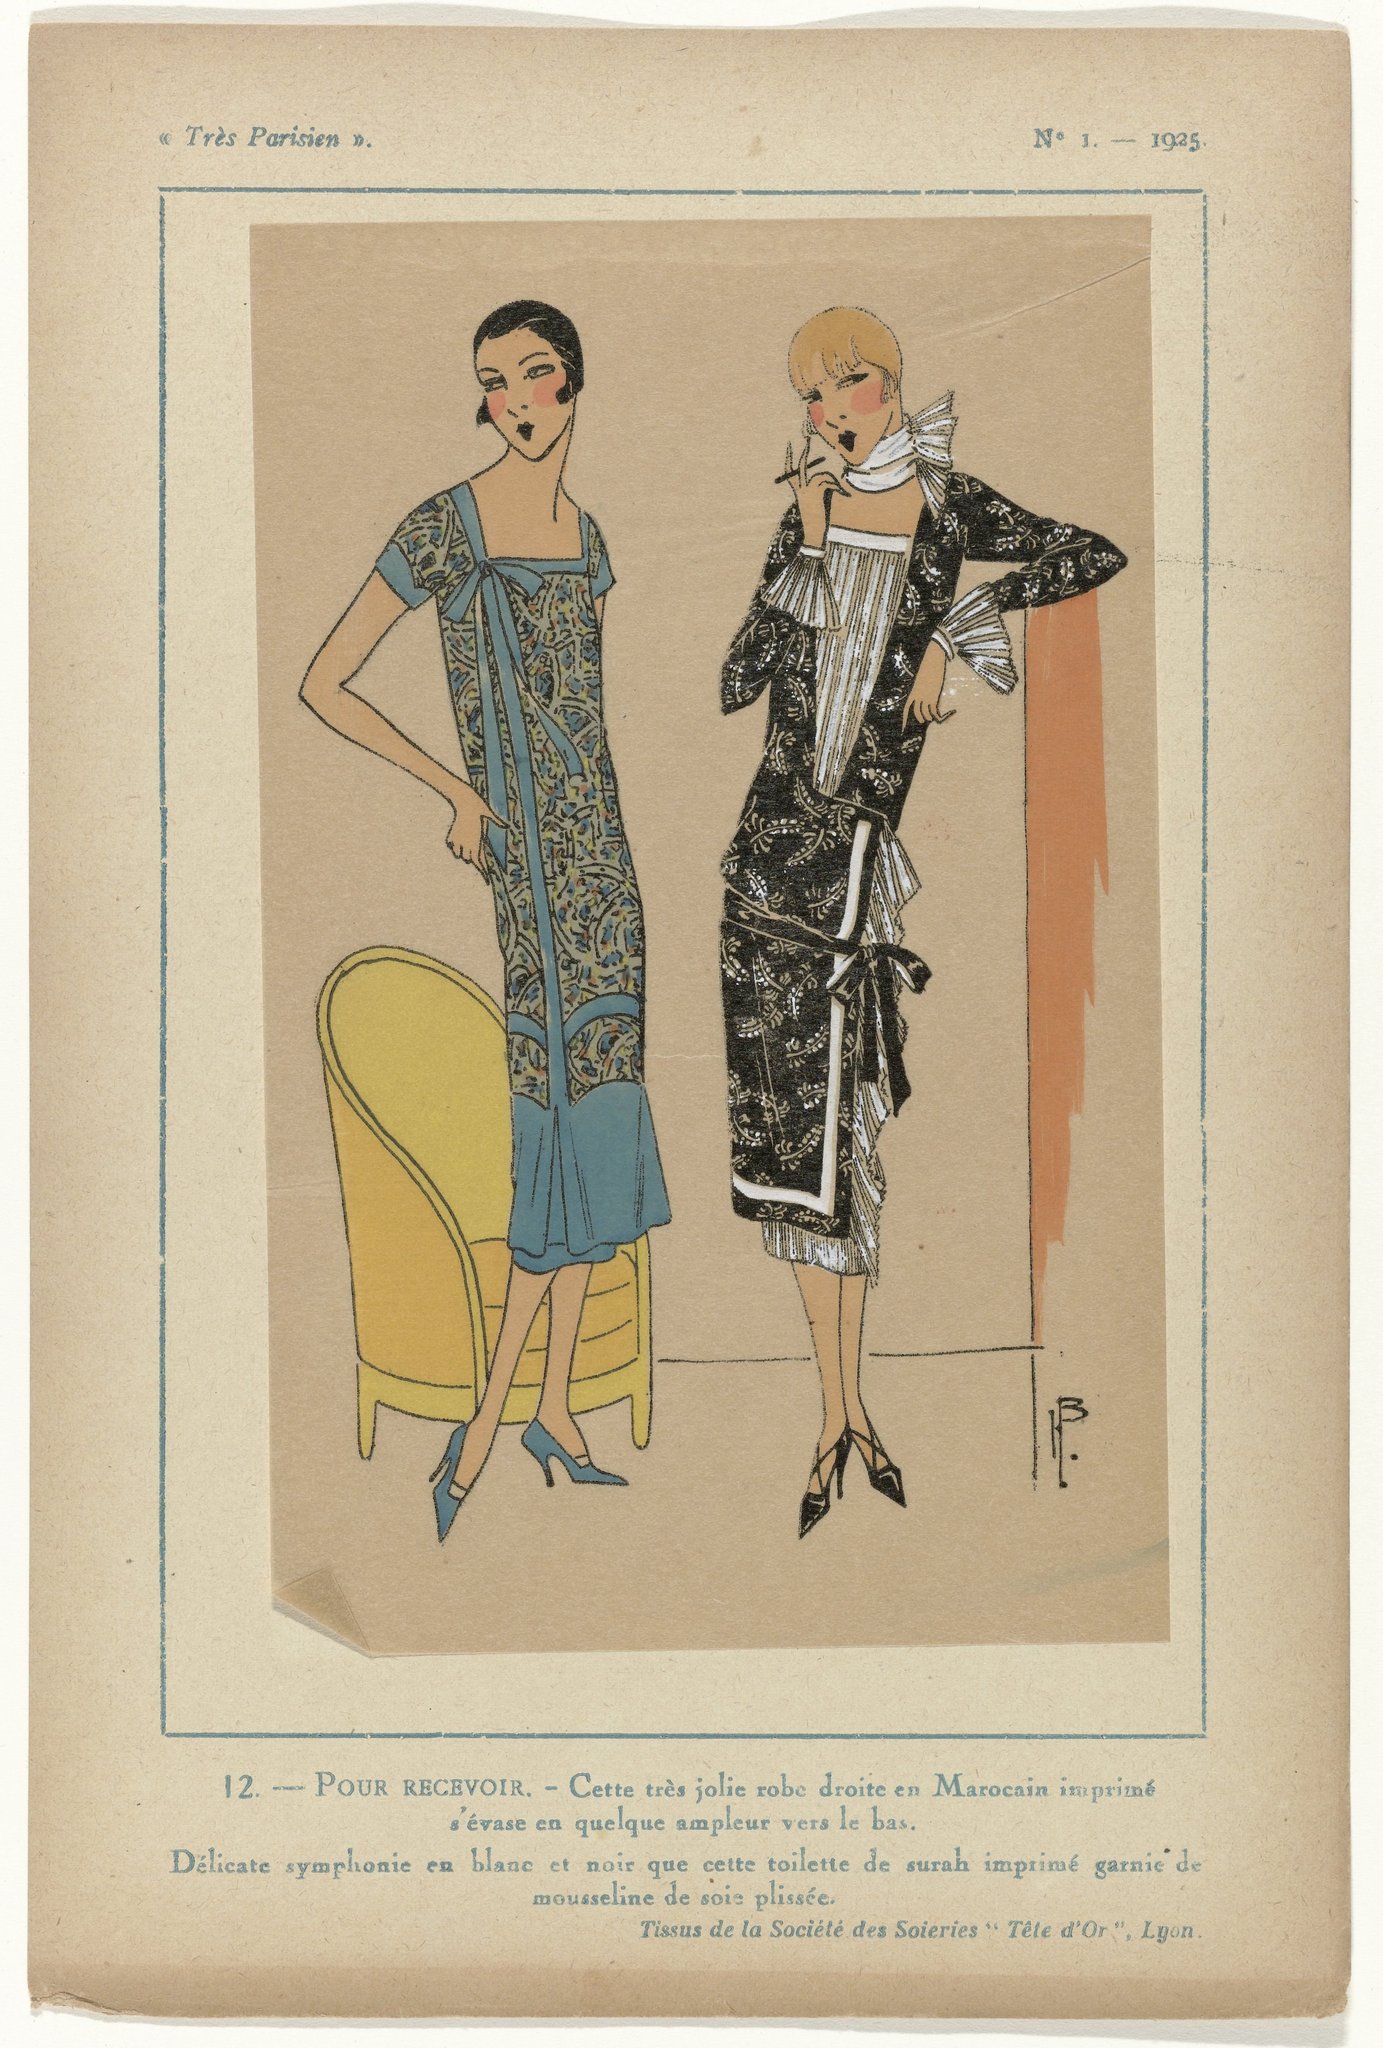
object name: fashion print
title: Très Parisien, 1925, No. 1, Pl. 12.- POUR RECEVOIR.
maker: g-p. joumard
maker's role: publisher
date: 1925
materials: paper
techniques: hand coloring, letterpress printing, lithography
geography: paris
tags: cigarette, dress, gown (afternoon dress) (+ women's clothes), fashion plates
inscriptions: caption: ‘POUR RECEVOIR. - Cette très jolie robe droite en Marocain imprimé s'évase en quelque ampleur vers le bas. Délicate symphonie en blanc et noir que cette toilette de surah imprimé garnie de mousseline de soie plissée. Tissus de la Société des Soieries "Tête d'or", Lyon.’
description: Twee middagjaponnen gemaakt van stoffen van de Société des Soieries "Tête d'Or", Lyon. Prent uit het modetijdschrift Très Parisien...La Mode, Le Chic, L'Élégance (1920-1936)